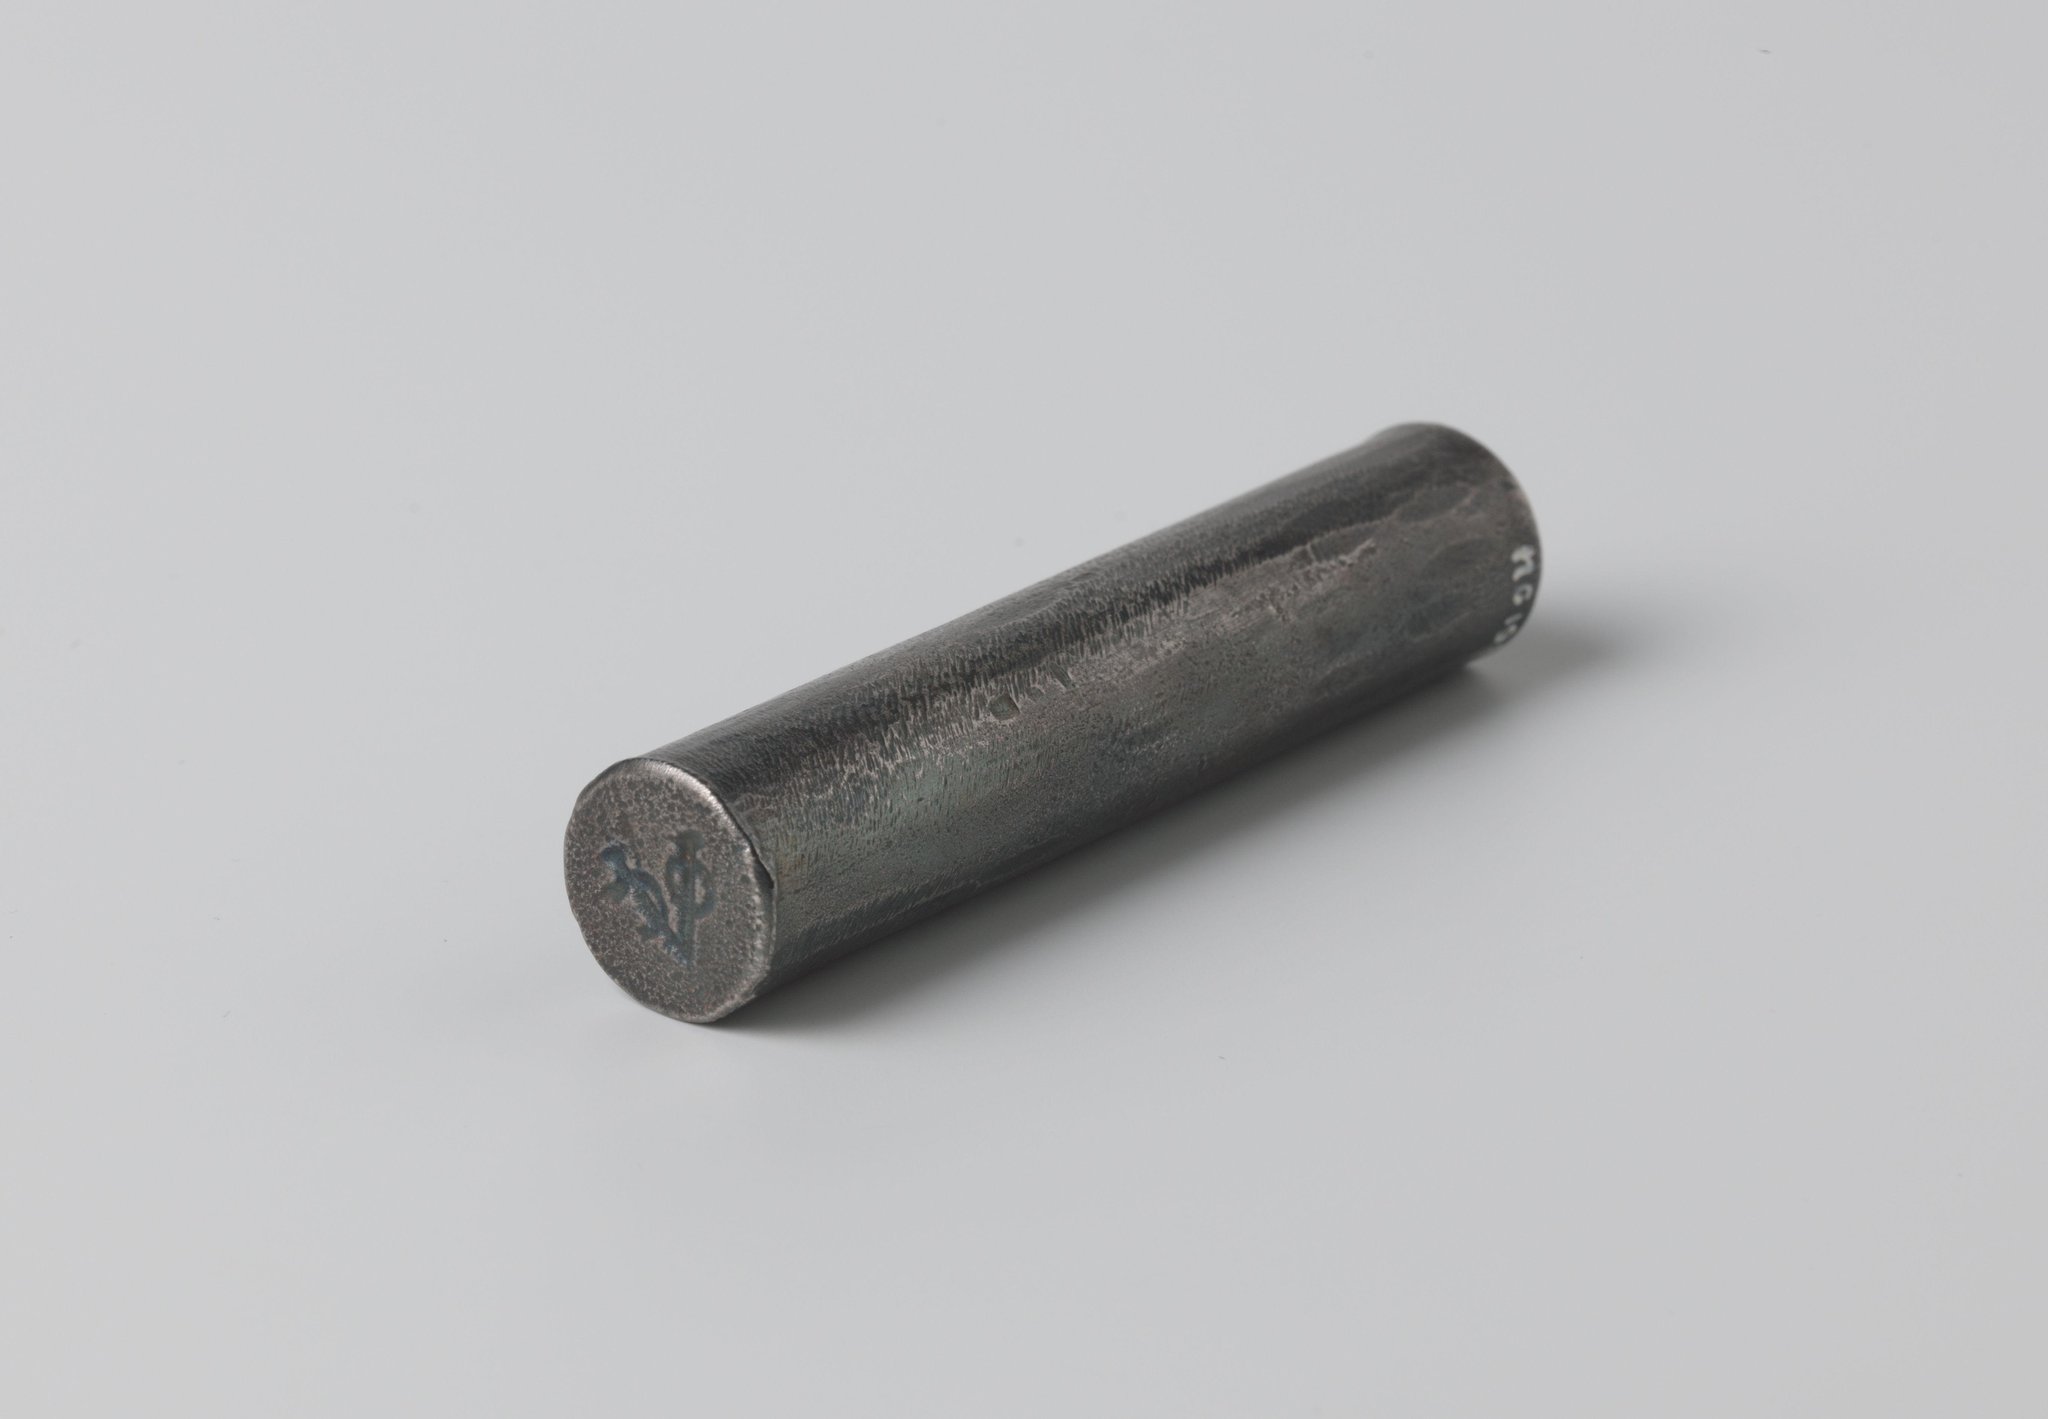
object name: carver's punch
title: Slagstempel van VOC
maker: Anonymous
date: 1700-1800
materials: iron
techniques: printing, casting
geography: netherlands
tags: netherlands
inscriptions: mark: ‘VOC’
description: Rand slagstempel met enigszins ruw oppervlak. Vlakke voor- en achterzijde. Centraal in voorzijde: merk en midden in achterzijde rond gat.